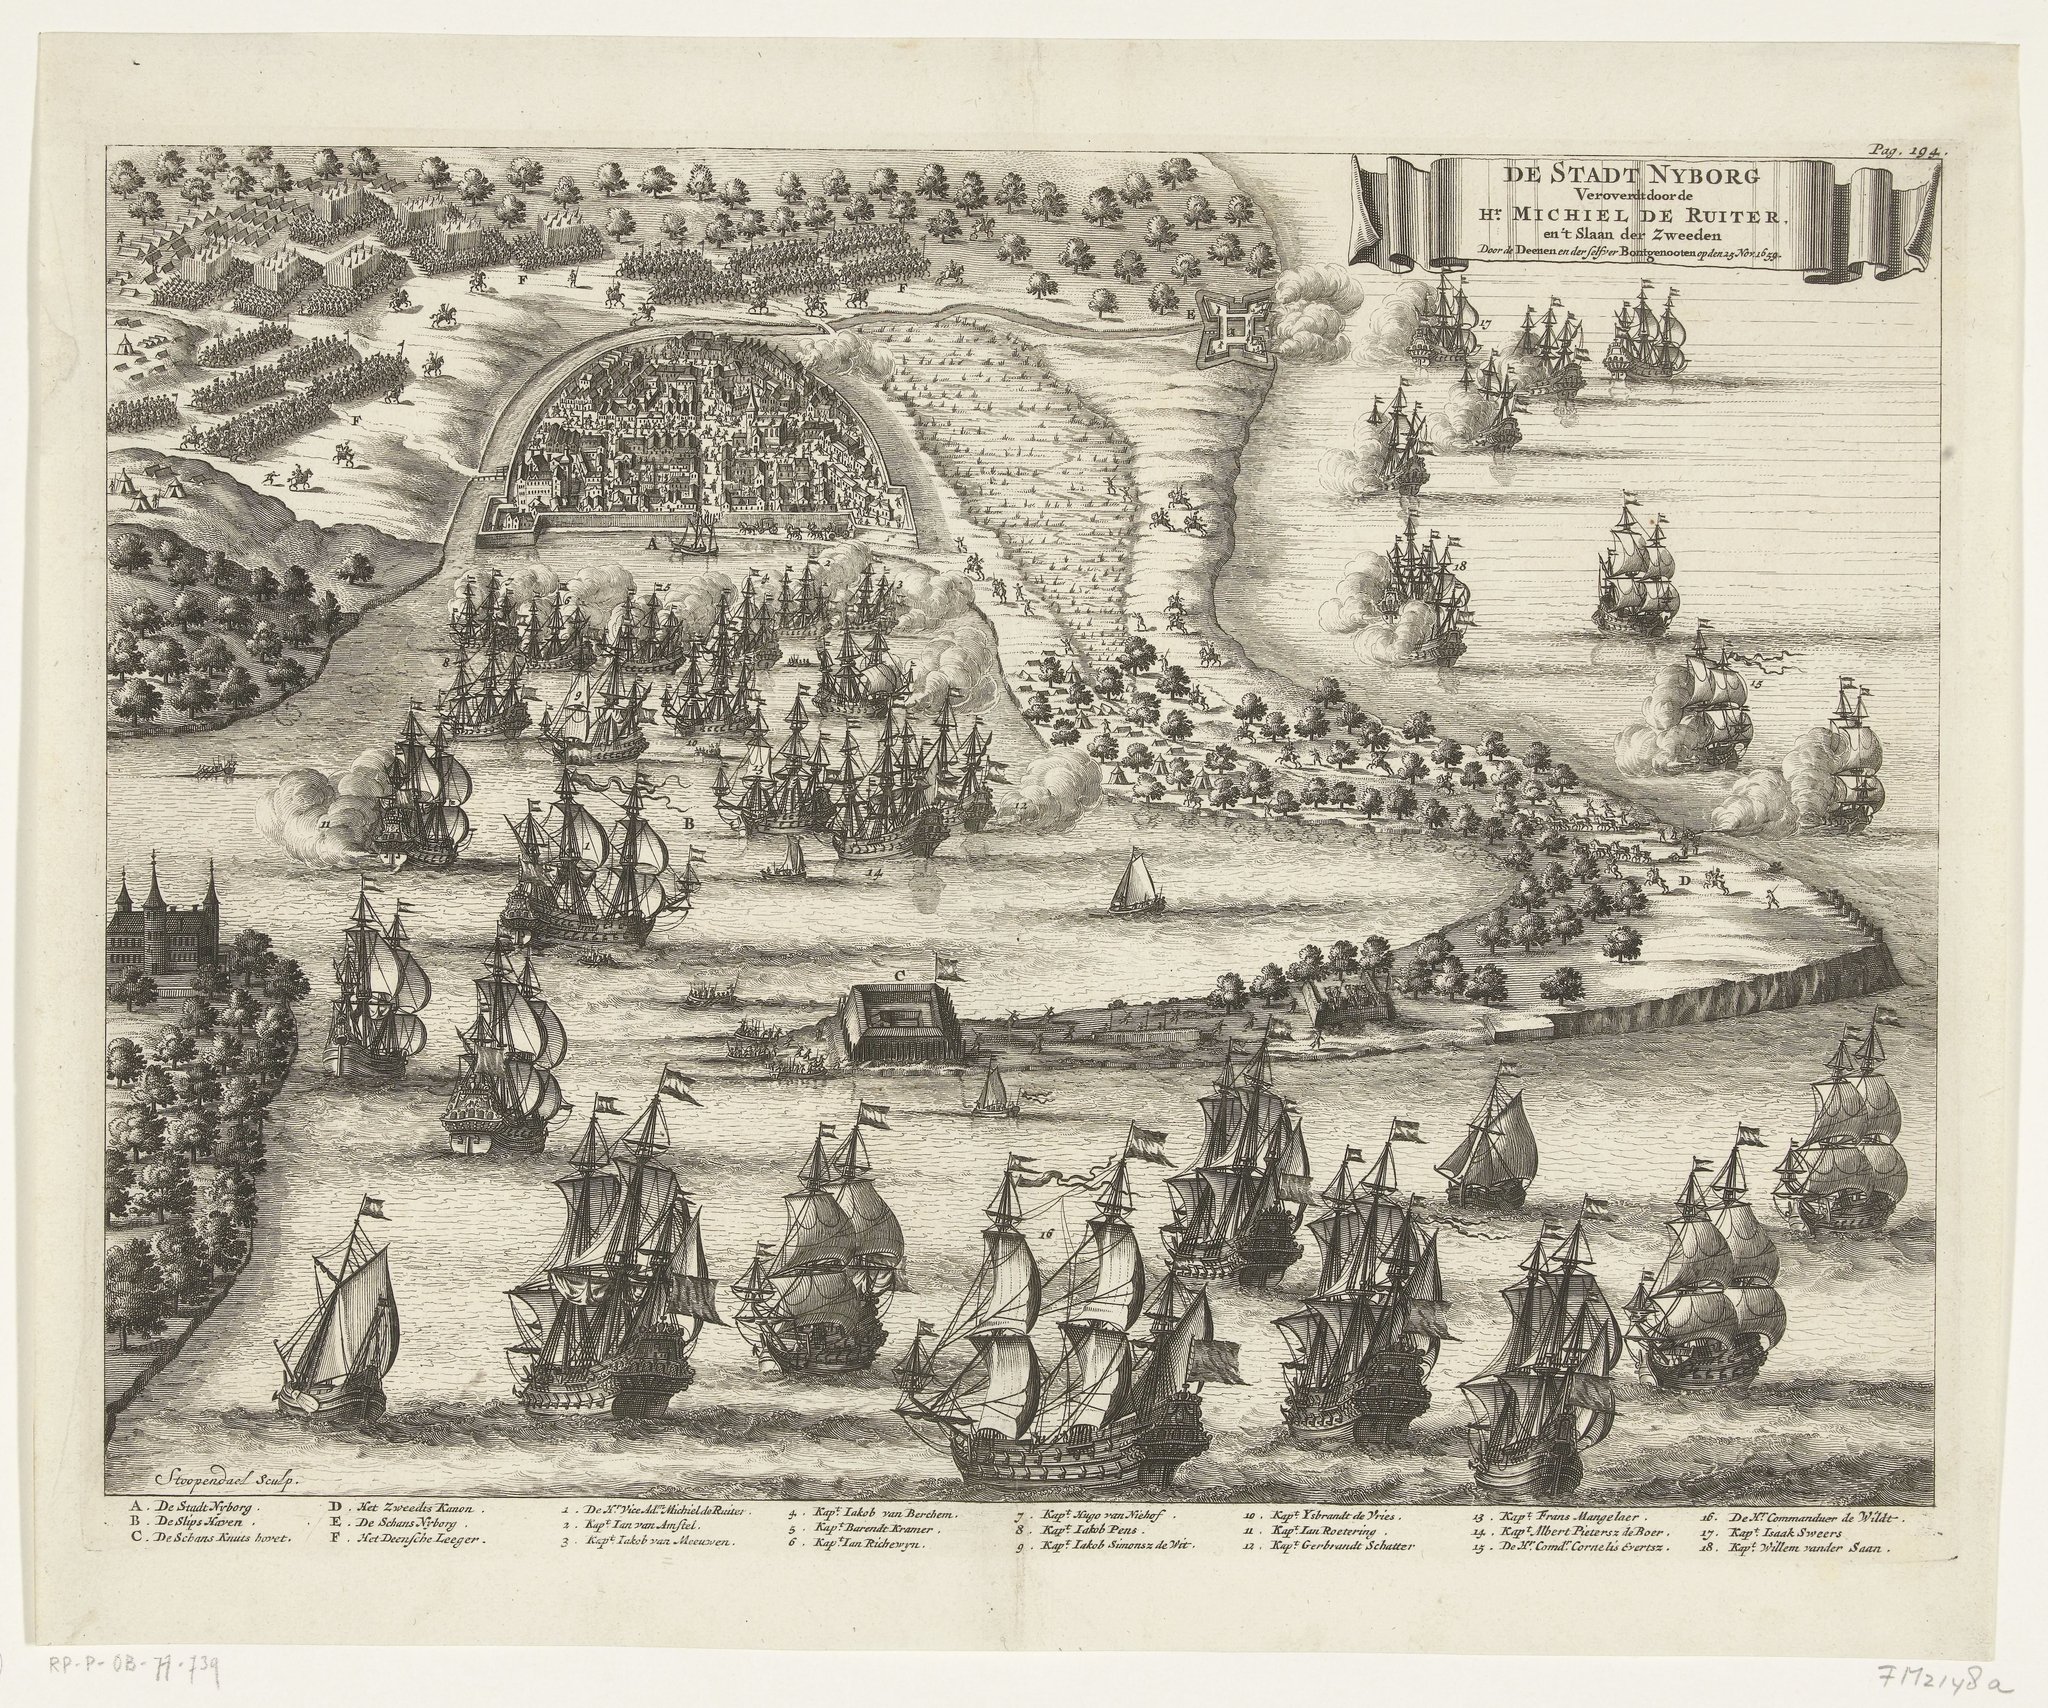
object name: history print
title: De Stadt Nyborg Veroverdt door de Hr. Michiel de Ruiter, en 't Slaan der Zweeden Door de Deenen en der selver Bontgenooten op den 25 Nov. 1659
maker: bastiaen stopendael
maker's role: print maker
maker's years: 1636-1693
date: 1685-1687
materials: paper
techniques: etching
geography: northern netherlands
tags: flushing, michiel adriaenszoon de ruyter, battle (+ naval force), battle (+ land forces)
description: Inname van de stad Nyborg door Michiel Adriaenszoon de Ruyter en het verslaan van het Zweedse leger door de Denen, 25 november 1659. Kaart van het deel van het eiland Funen en plan van de stad met haven. Hollandse vloot op de voorgrond. Rechtsboven de titel in cartouche en gemerkt: Pag. 194. In het onderschrift de legenda's A-F en 1-18.